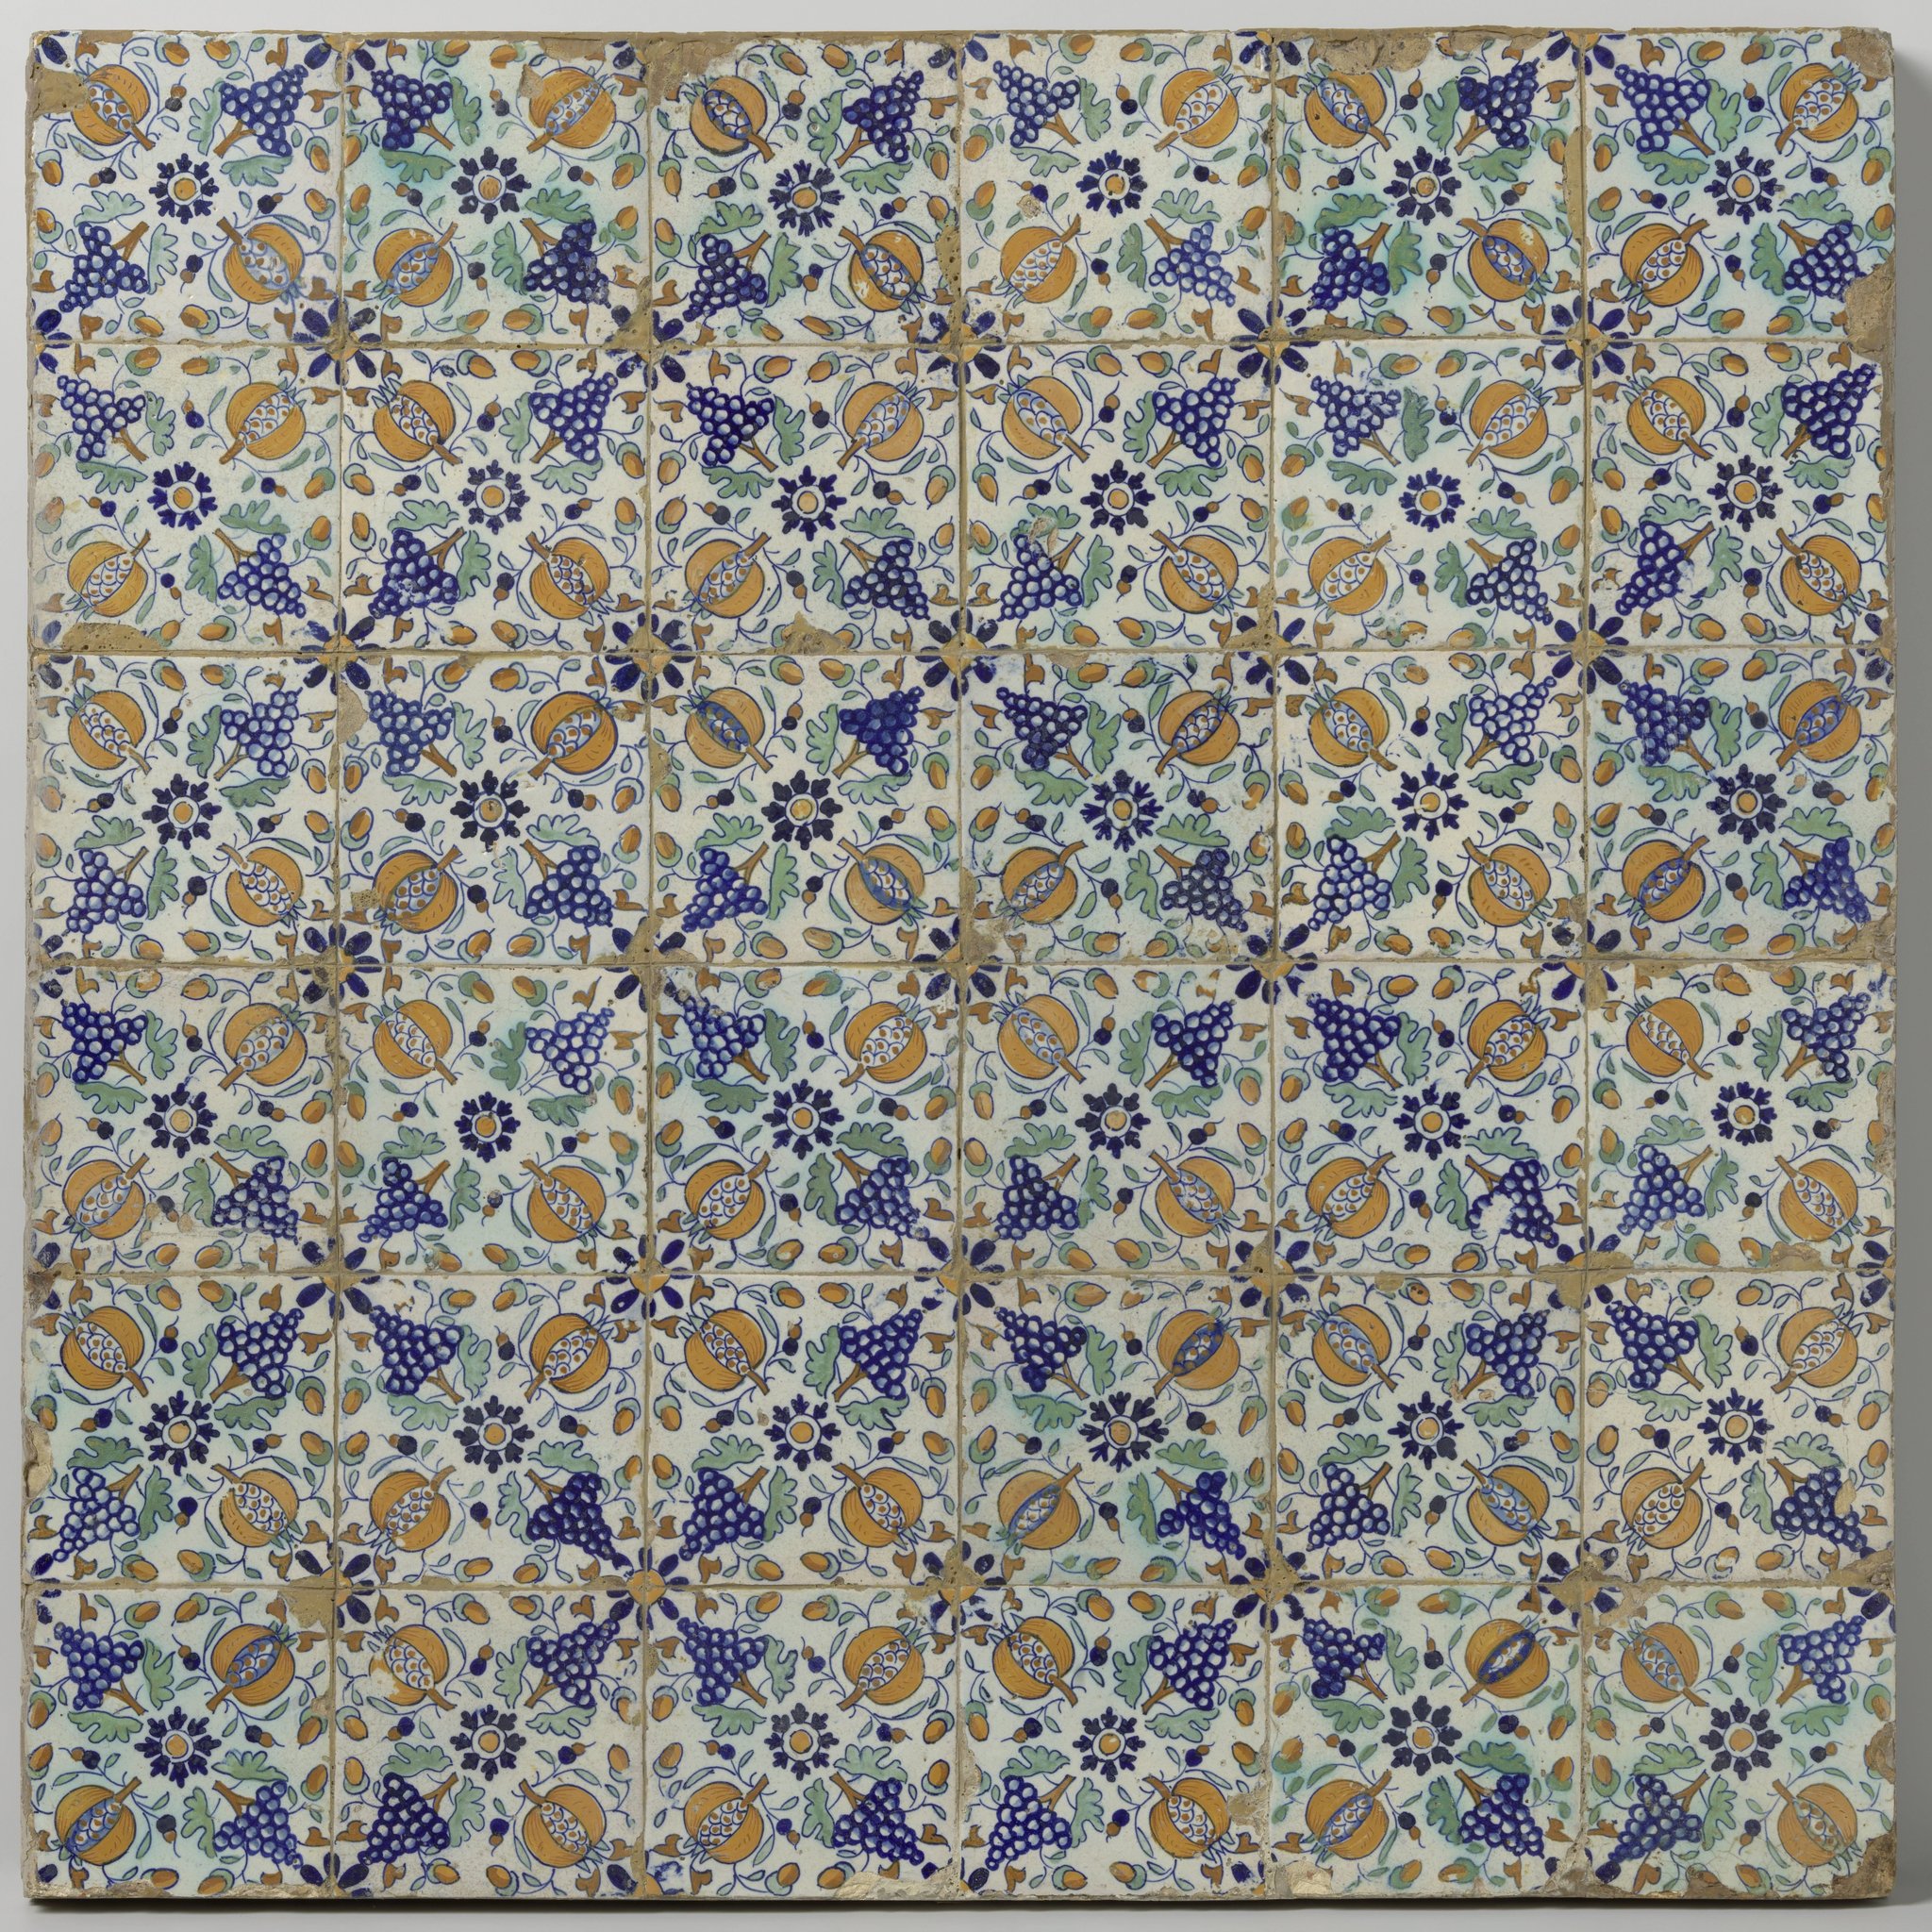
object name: tegelveld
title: Veld van zesendertig tegels met rozetten, druiventrossen en granaatappels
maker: Anonymous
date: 1600-1625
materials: earthenware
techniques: maiolica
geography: netherlands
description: Veld van zesendertig tegels (6 x 6) elk met een veelkleurig (blauw, groen, geel en oranje) geschilderde voorstelling. In het midden een rozet omgeven door druiventrossen en granaatappels. In de hoeken, een kwart rozet.